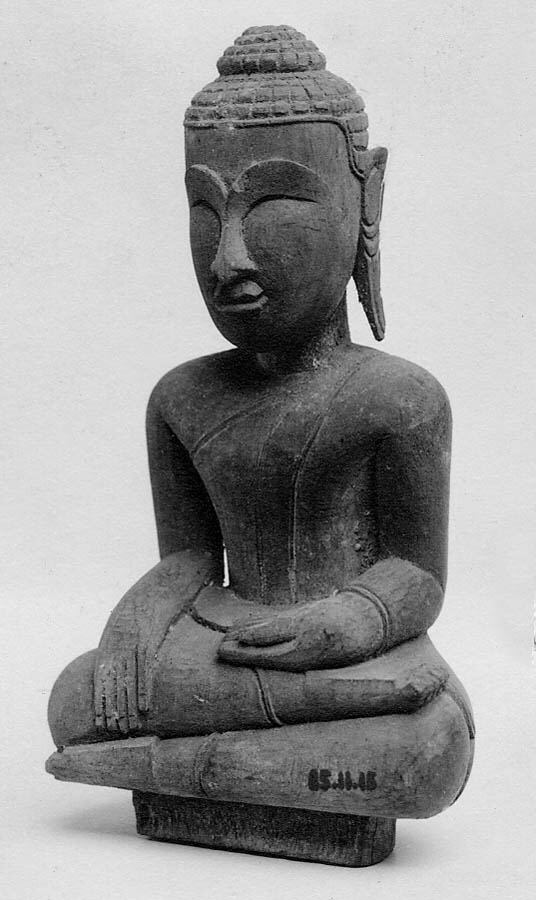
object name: statuette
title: Seated Buddha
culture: cambodian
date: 1801-1900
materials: wood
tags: buddhism,buddha